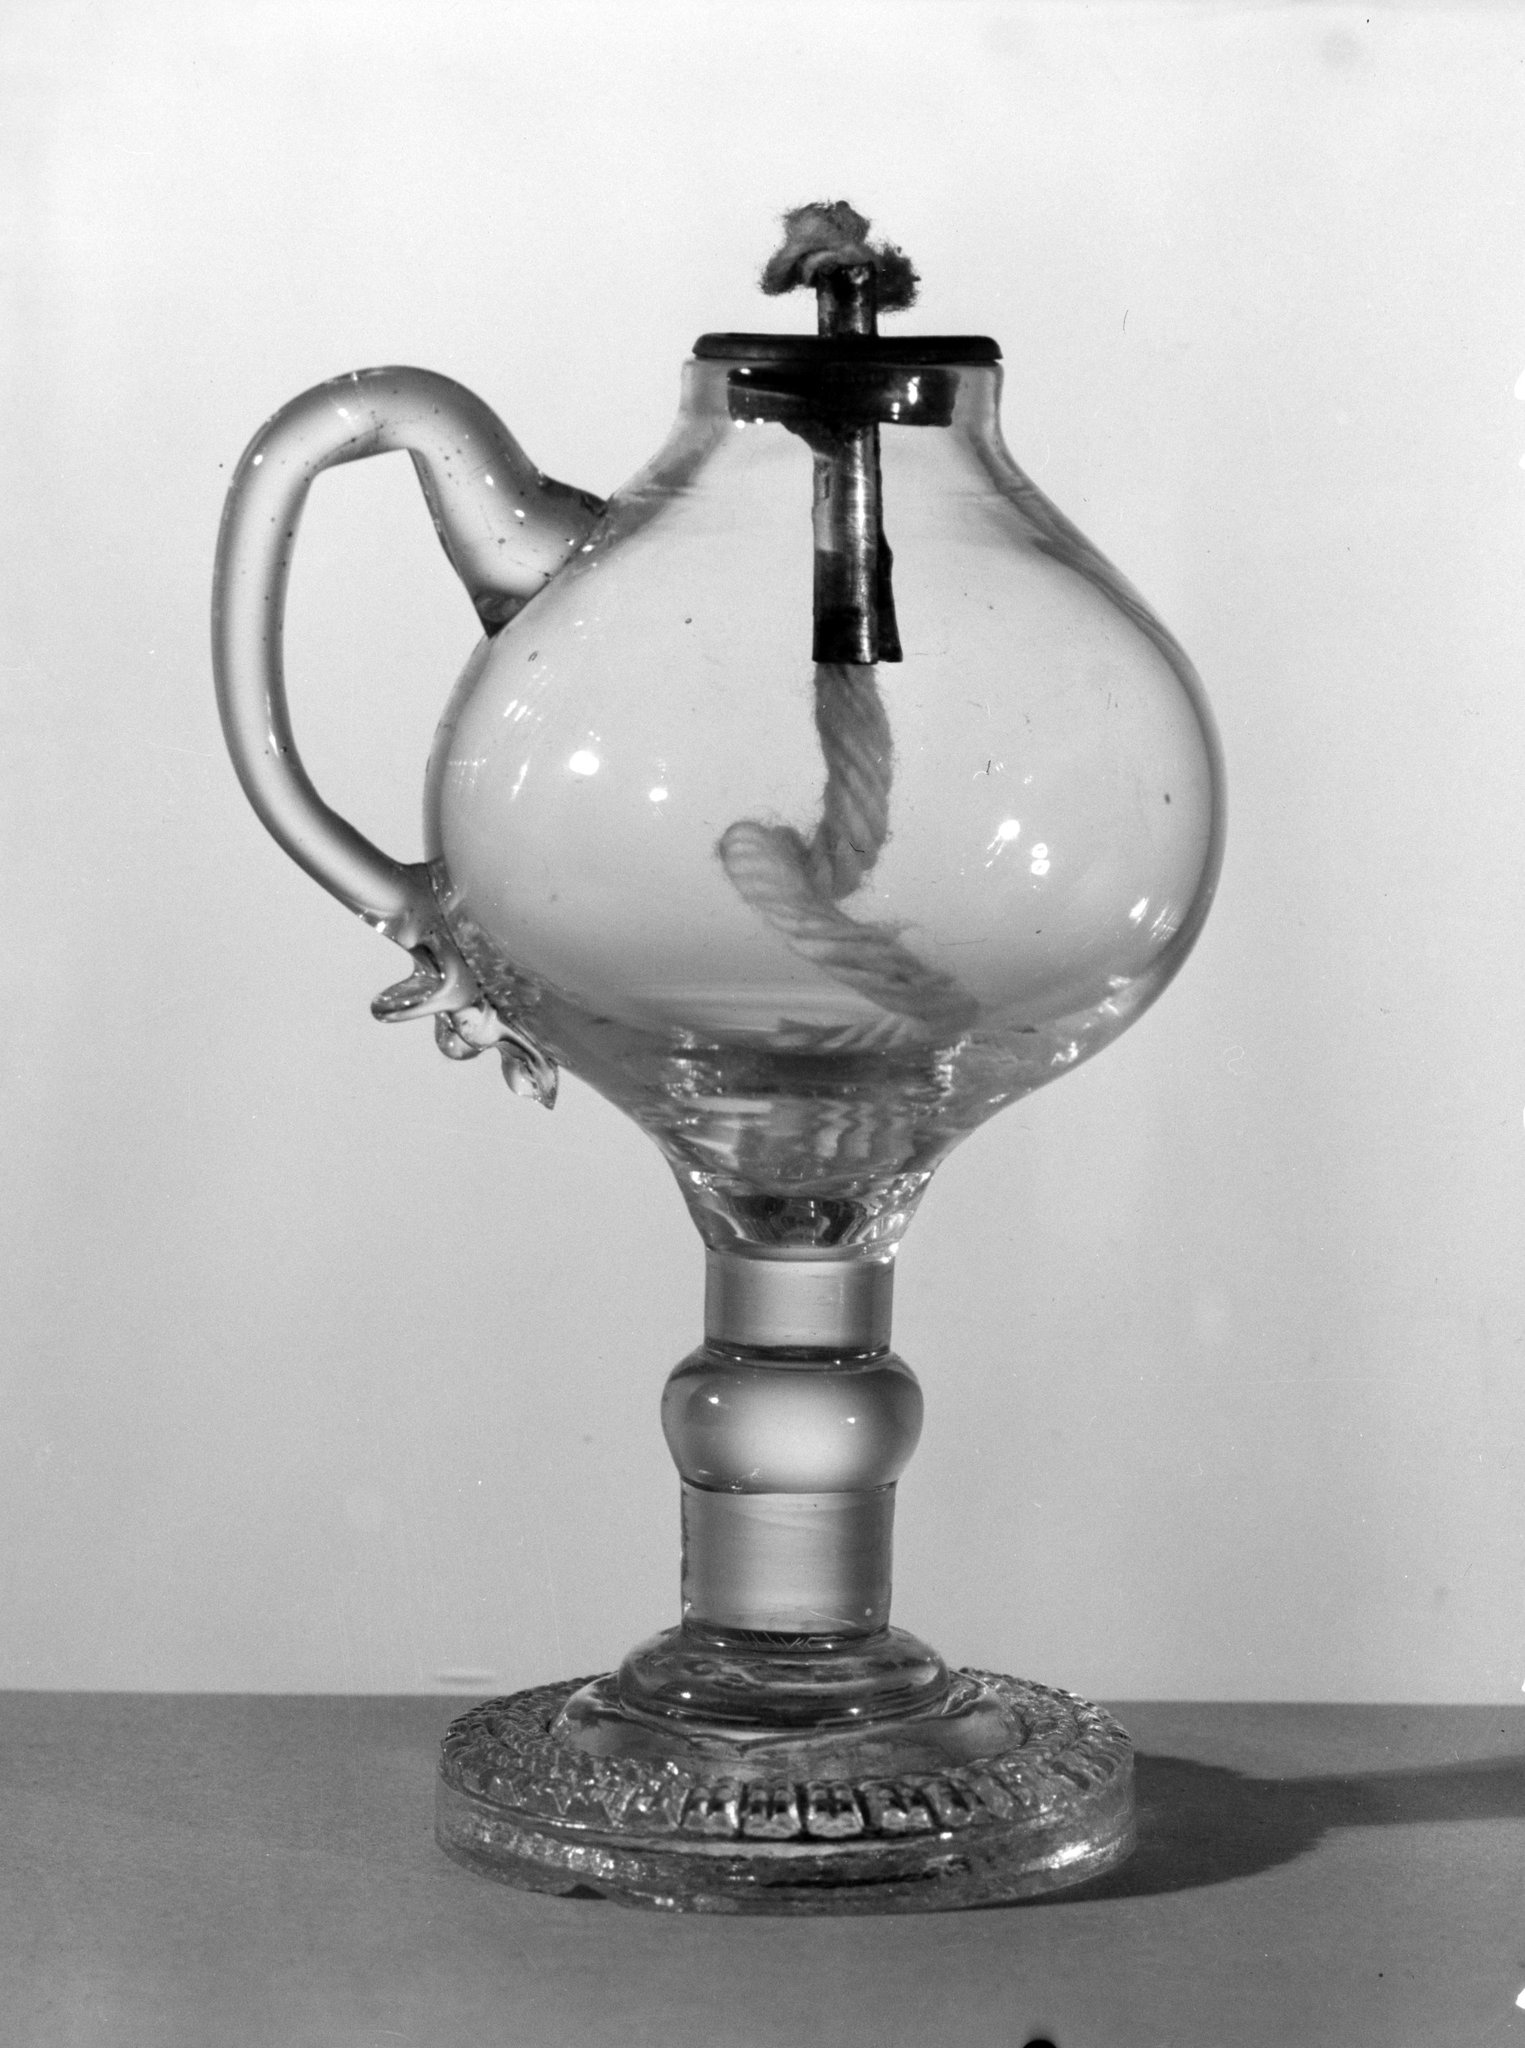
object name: lamp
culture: american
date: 1827-1835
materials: cork, glass, tin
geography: united states